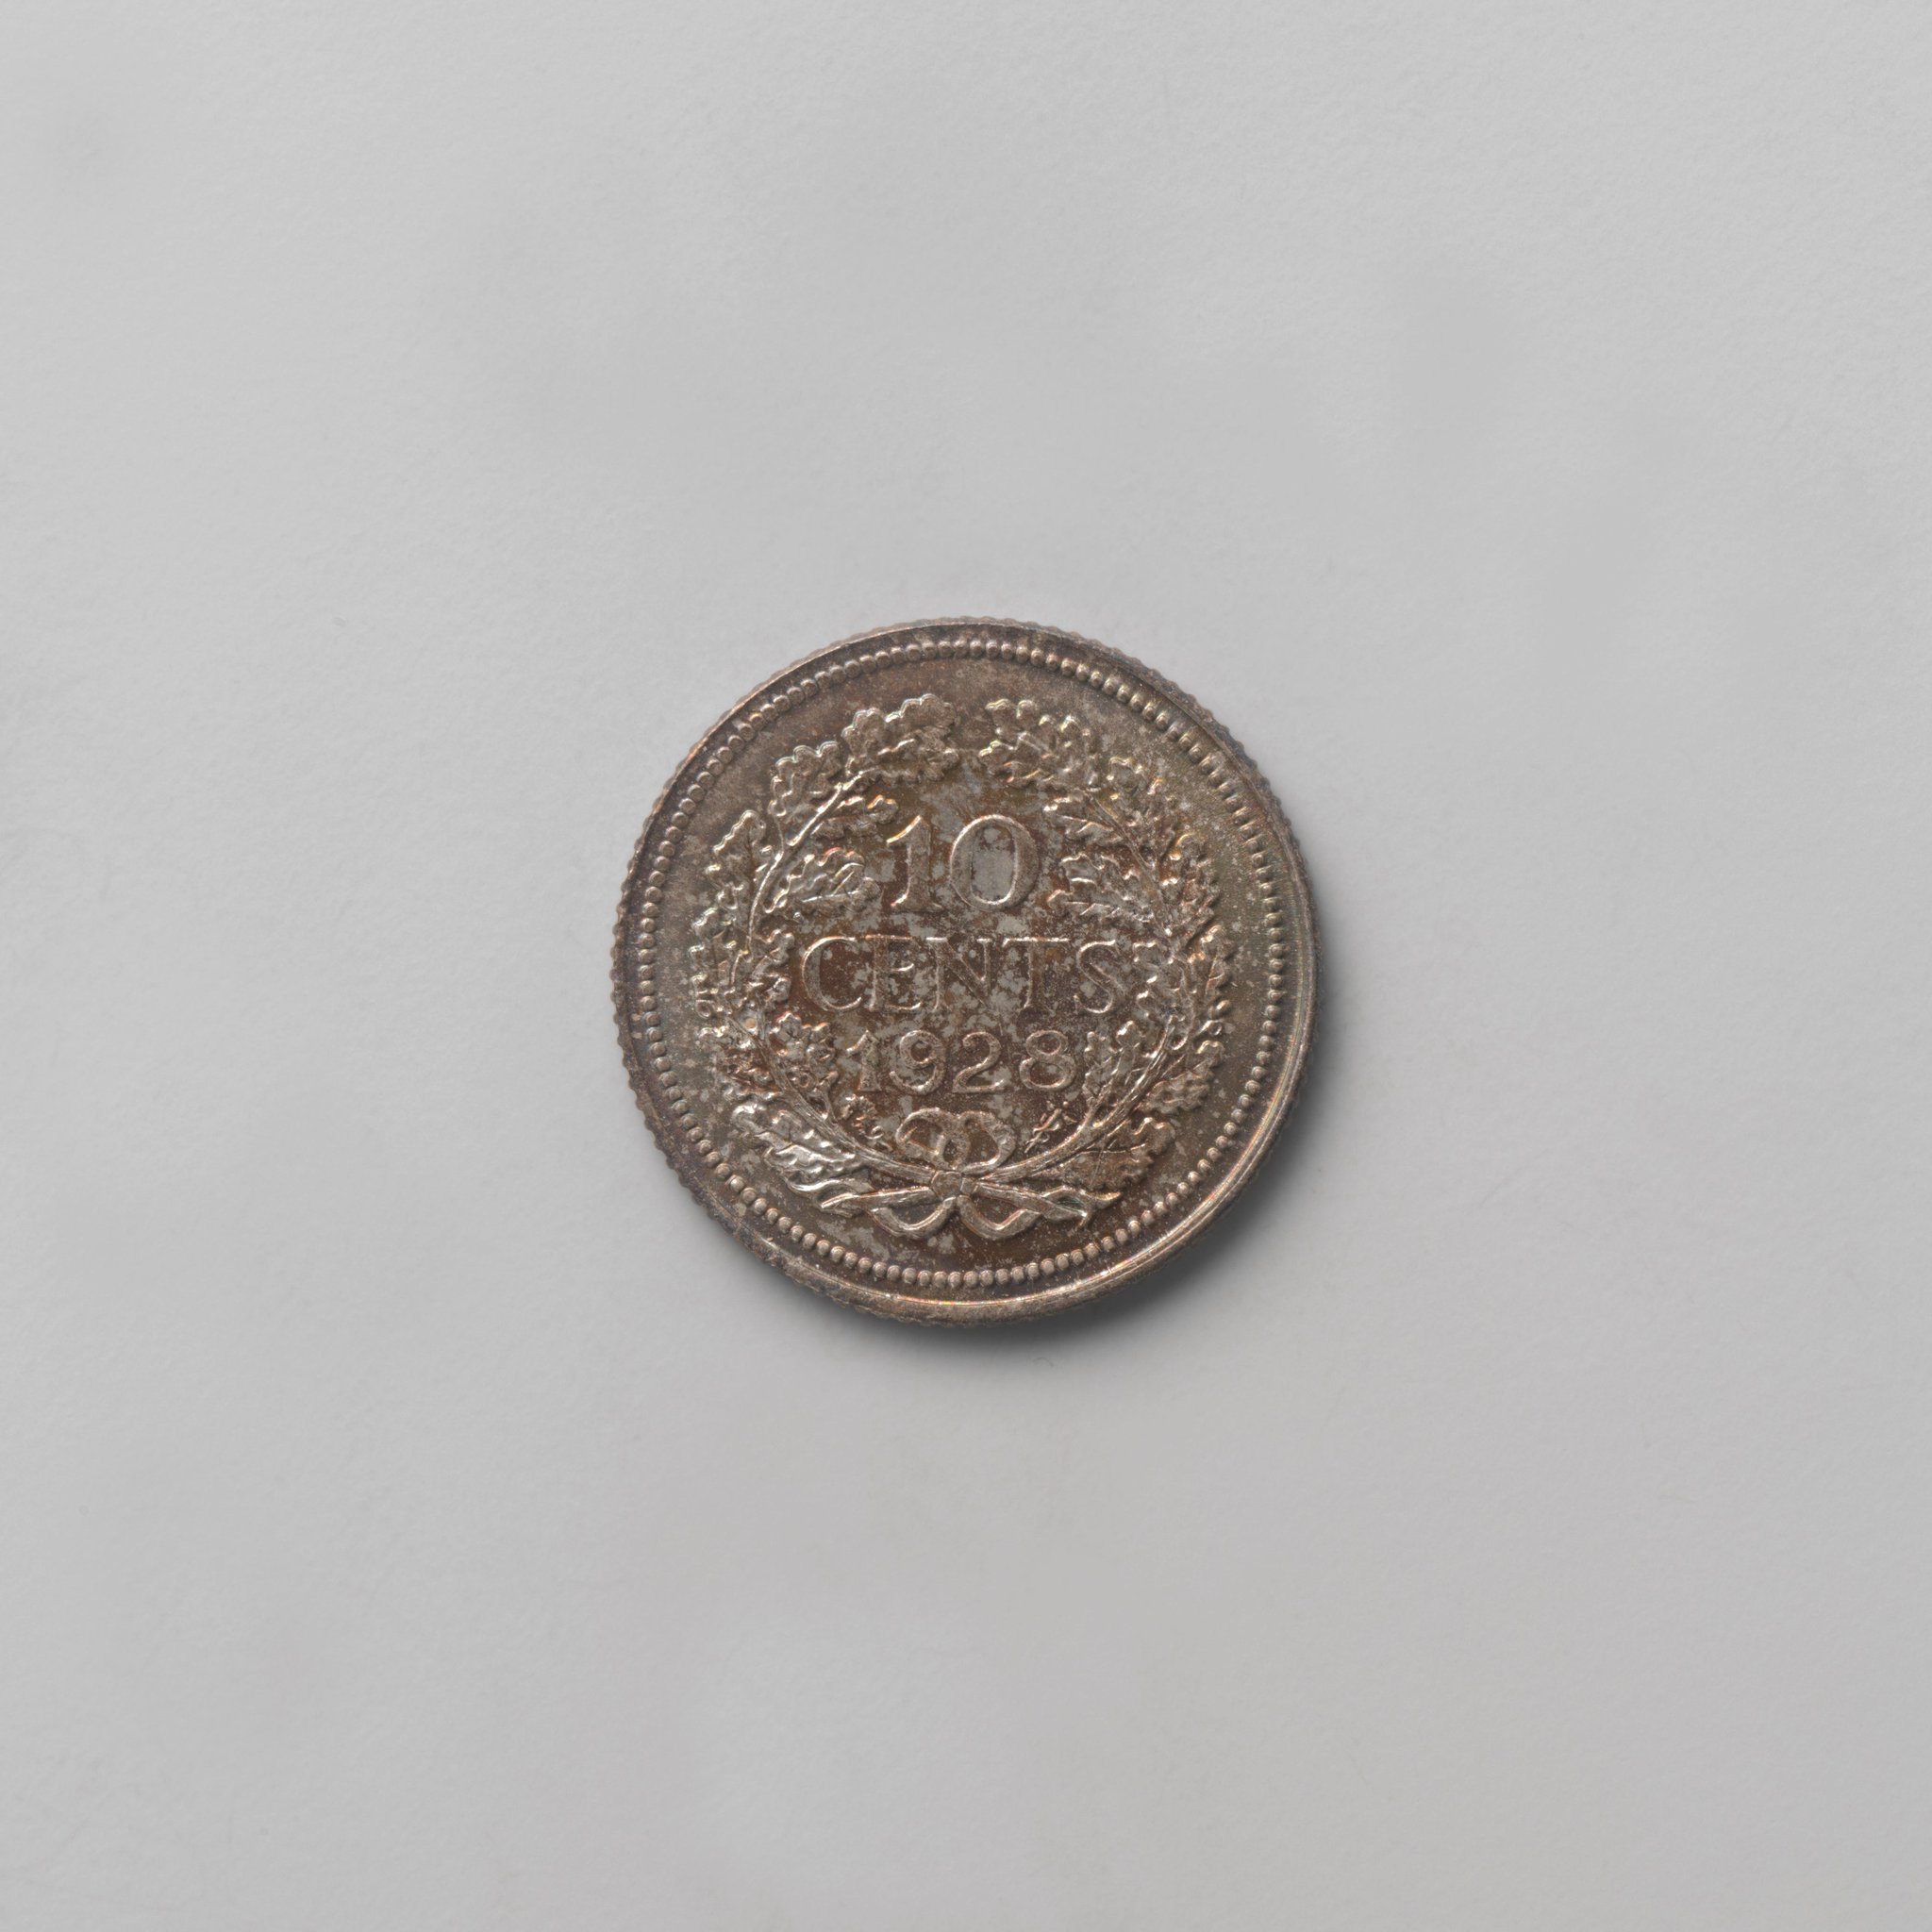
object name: coin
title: Nederlandse10 cent,1928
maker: wilhelmina of the netherlands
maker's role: print maker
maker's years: 1880-1962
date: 1928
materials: silver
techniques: striking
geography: utrecht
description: Zilveren munt. Voorzijde: hoofd naar links. Keerzijde: binnen twee samengebonden eiketakken waarde-aanduiding 10 cents en jaartal. Kartelrand.